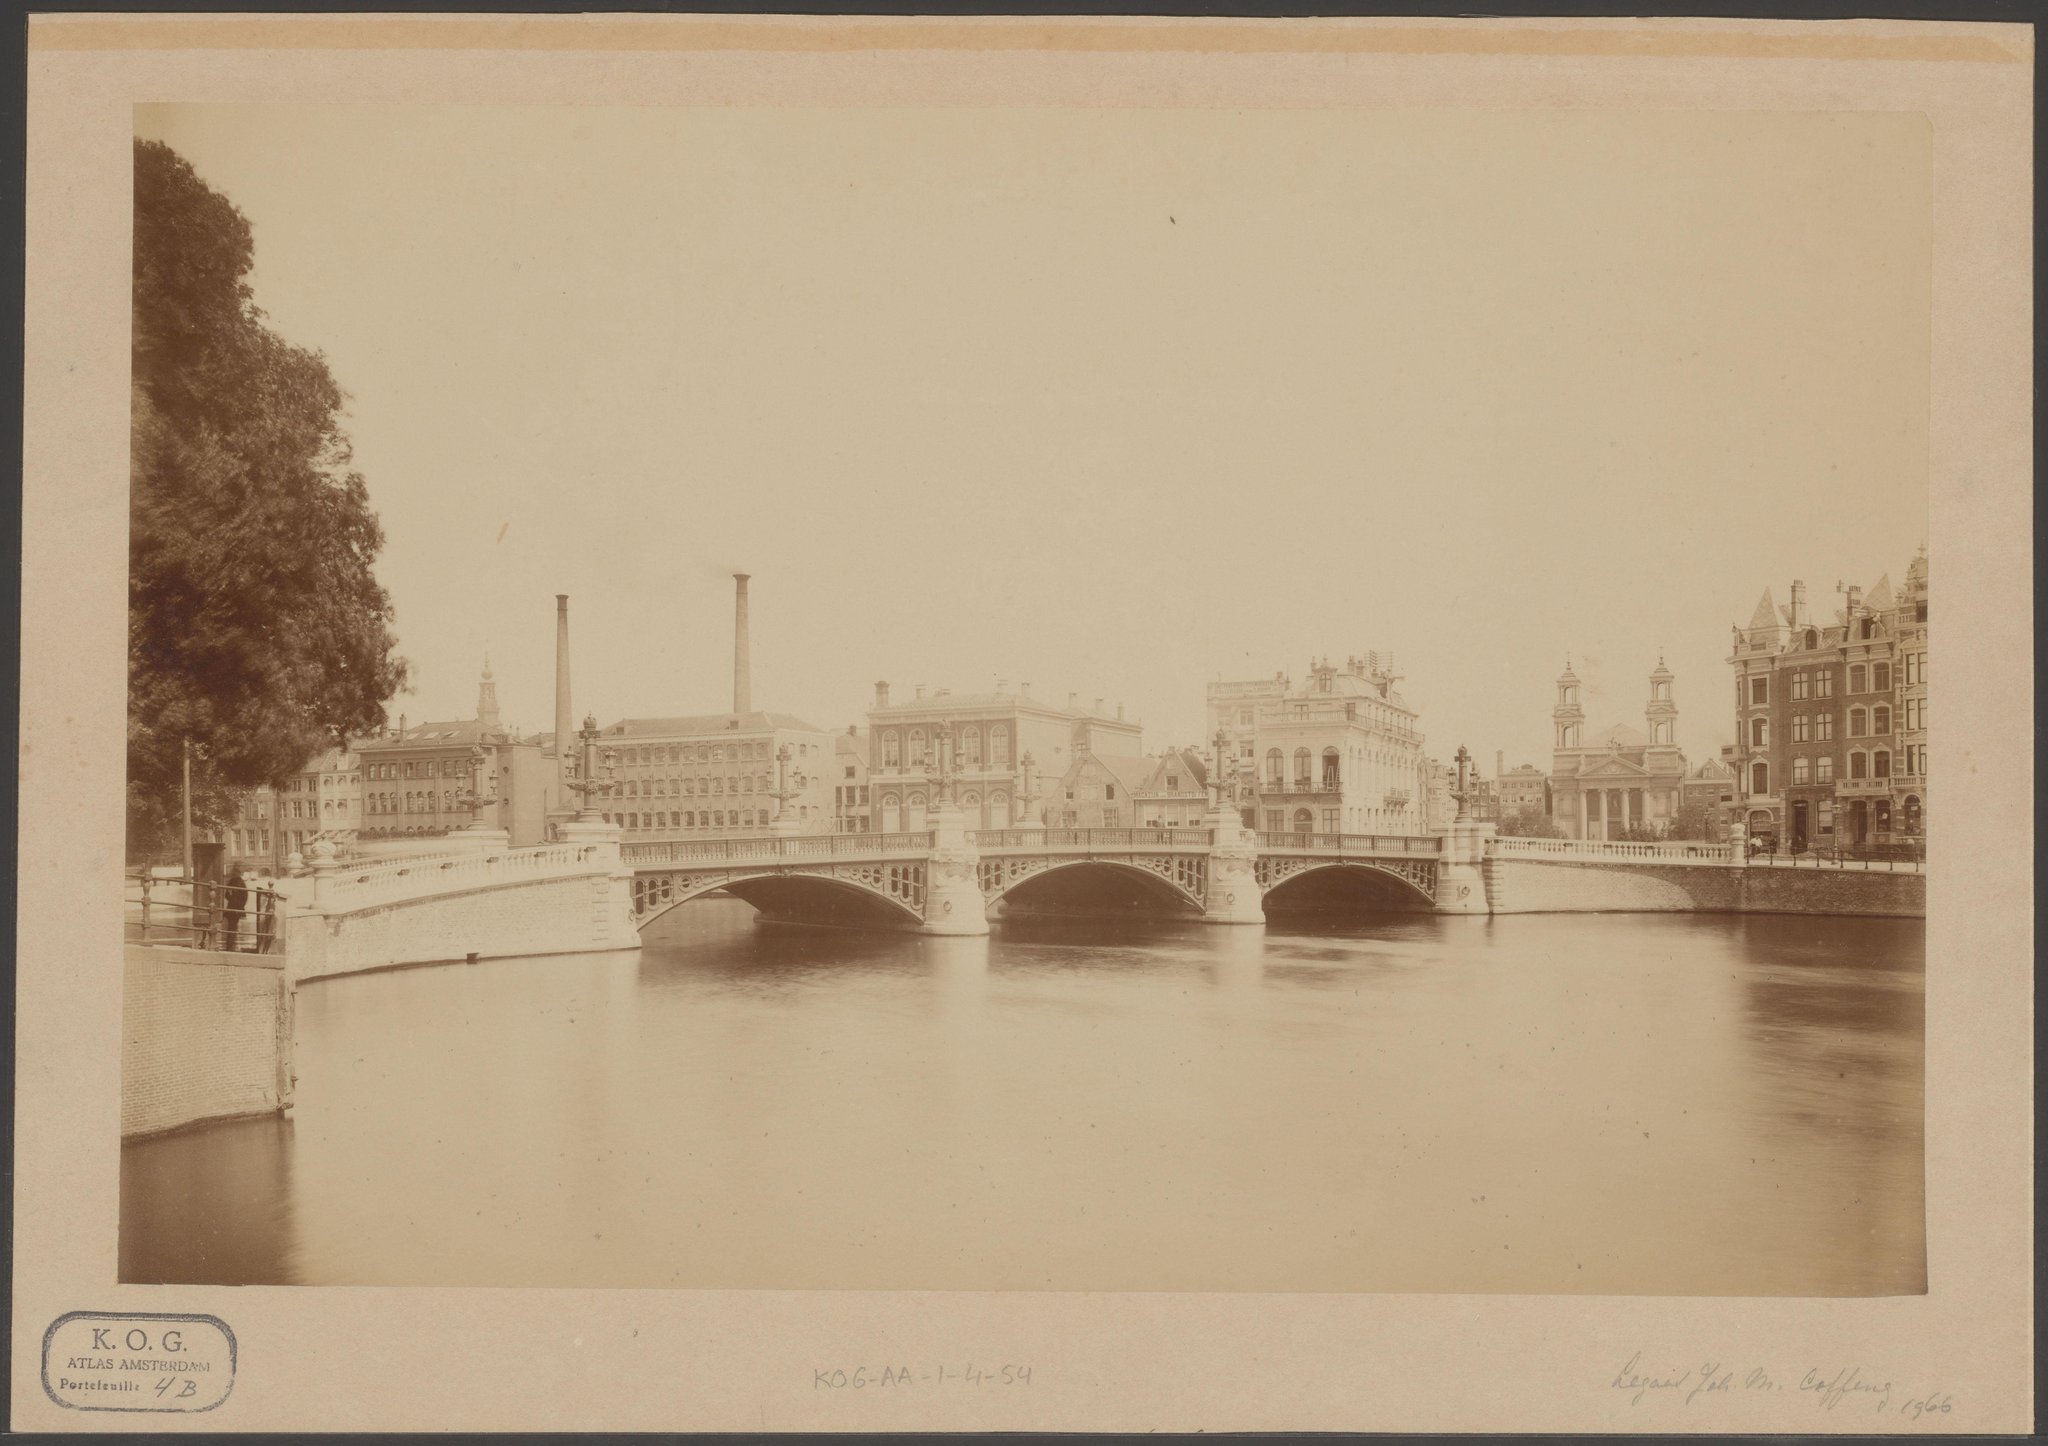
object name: photograph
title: Gezicht op de Blauwbrug en de Mozes en Aäronkerk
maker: Anonymous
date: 1883-1915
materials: cardboard, paper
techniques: albumen print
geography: amsterdam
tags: city-view in general; 'veduta', canal, bridge in city across river, canal, etc.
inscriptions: inscription: ‘Legaat Joh. M. Coffeng / 1966’, collector's mark: ‘4B’ Lugt 1641b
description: Onderwerpsrubriek binnen de Atlas Amsterdam: Amstel van Blauwbrug tot Hogesluis.